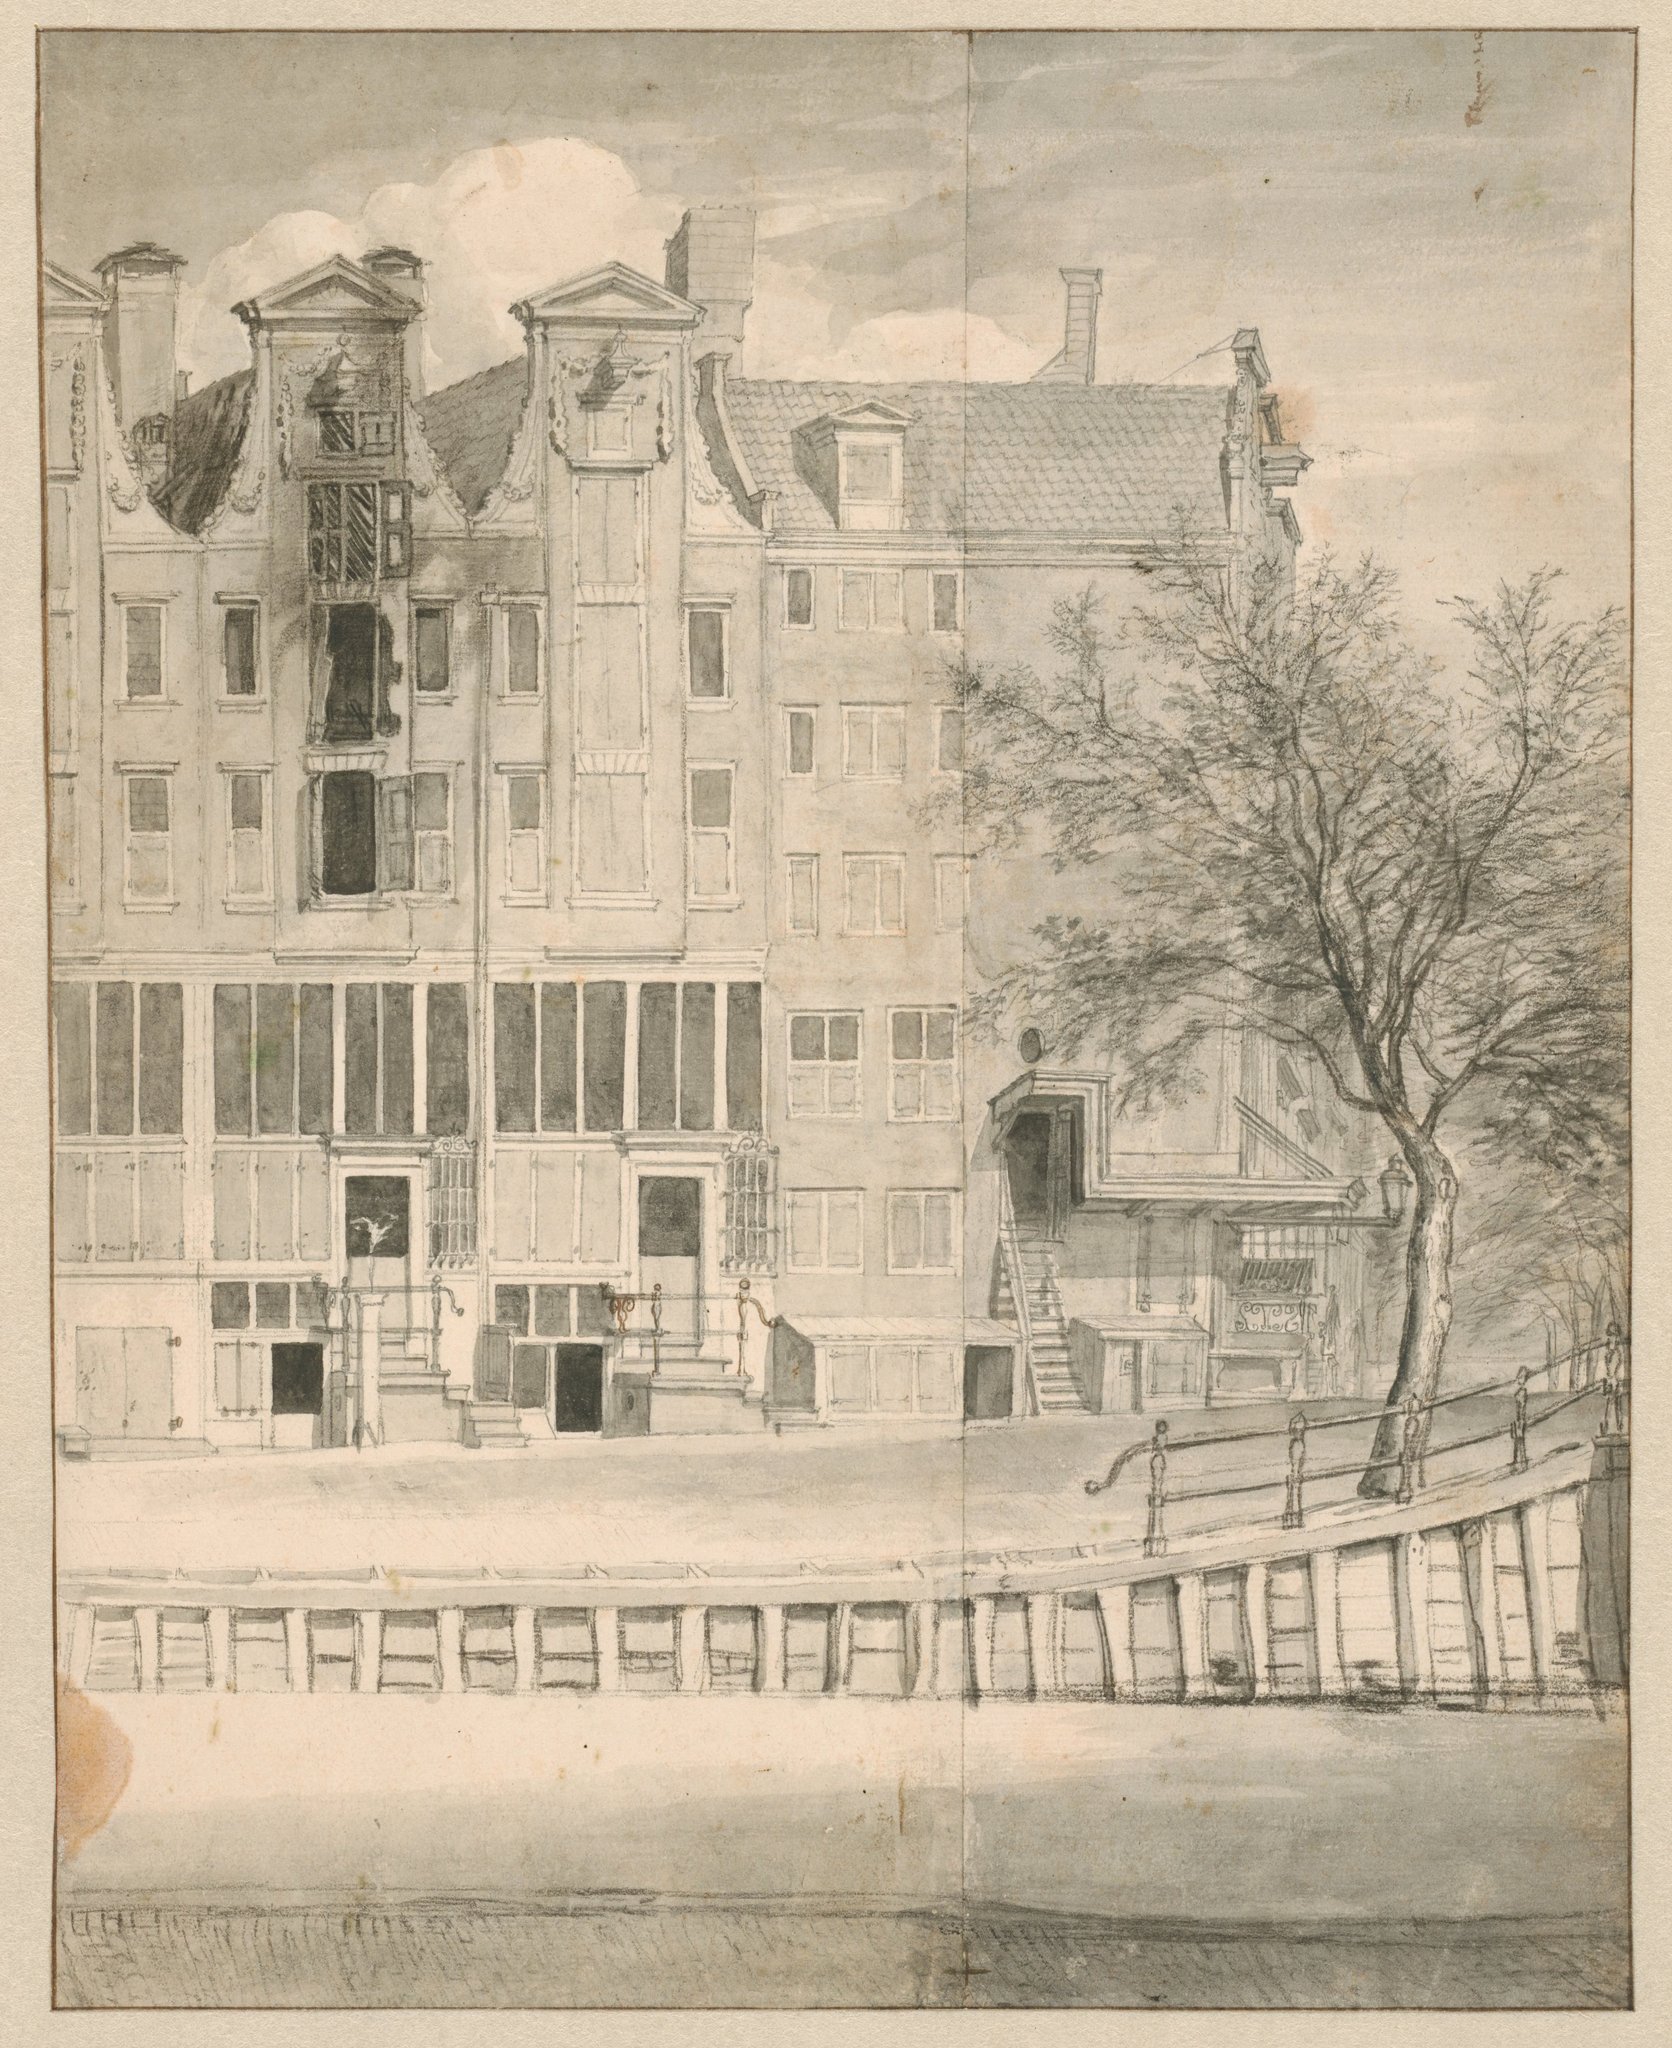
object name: drawing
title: Uitgebrand huis op de Leidsegracht, 1684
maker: jan van der heyden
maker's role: draughtsman, painter, print maker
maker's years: 1637-1712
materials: chalk, ink, paper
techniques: brush, pen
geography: amsterdam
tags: print maker, jan van der heyden, urban housing, ruin of a building ~ architecture, canals, waters (in city), fire-fighting, fire-extinguishing equipment, severe winters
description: Ontwerptekening voor illustratie in: Heyden, Jan van der. Beschryving der nieuwlyks uitgevonden en geoctrojeerde slang-brand-spuiten en haare wyze van brand-blussen, tegenwoordig binnen Amsterdam in gebruik zijnde (…). 1e druk. Amsterdam: Jan Rieuwertsz. (II), 1690. En: Heyden, Jan van der. Beschryving der nieuwlyks uitgevonden en geoctrojeerde slang-brand-spuiten en haare wyze van brand-blussen, tegenwoordig binnen Amsterdam in gebruik zijnde (…). 2e druk. Amsterdam: erfgenamen Jan van der Heyden, 1735. Voor eerste bekende staat van de prent zie RP-P-OB-2365. Voor tweede bekende staat van de prent zie RP-P-OB-82.098. Voor derde bekende staat van de prent zie RP-P-AO-28-76-14, RP-P-OB-77.747 en RP-P-OB-102.829. Voor tegendruk van derde bekende staat van de prent zie RP-P-OB-82.097.